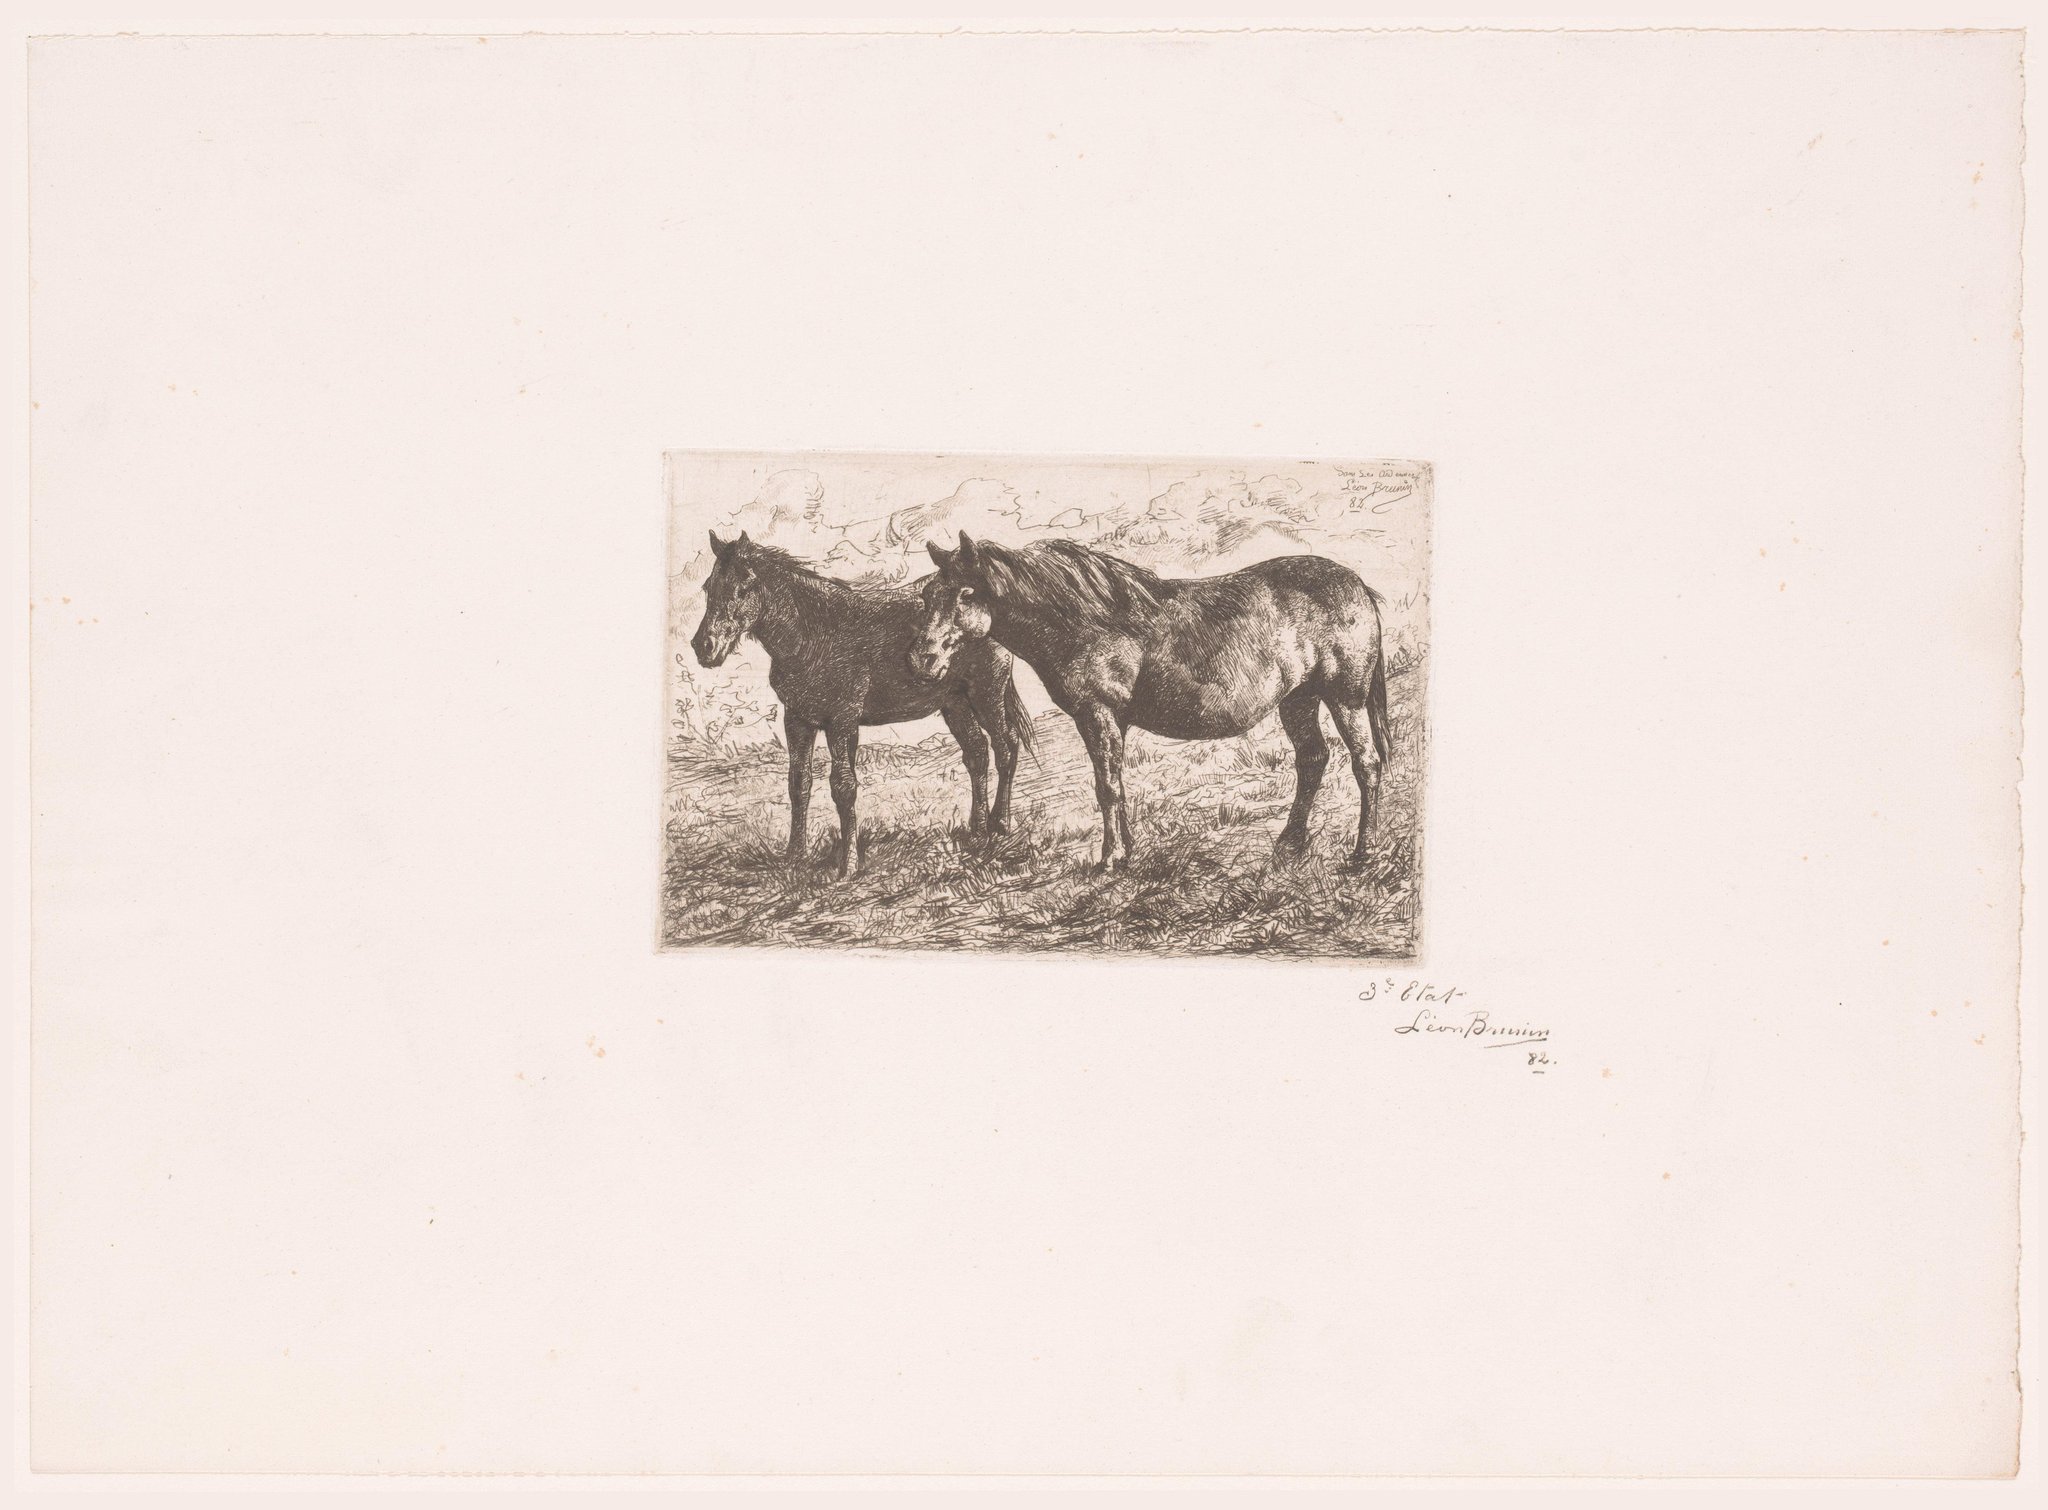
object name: print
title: Twee paarden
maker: léon brunin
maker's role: print maker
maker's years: 1861-1949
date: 1882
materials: paper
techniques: etching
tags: horse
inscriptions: annotation: ‘3e Etat’, collector's mark: Lugt 2228